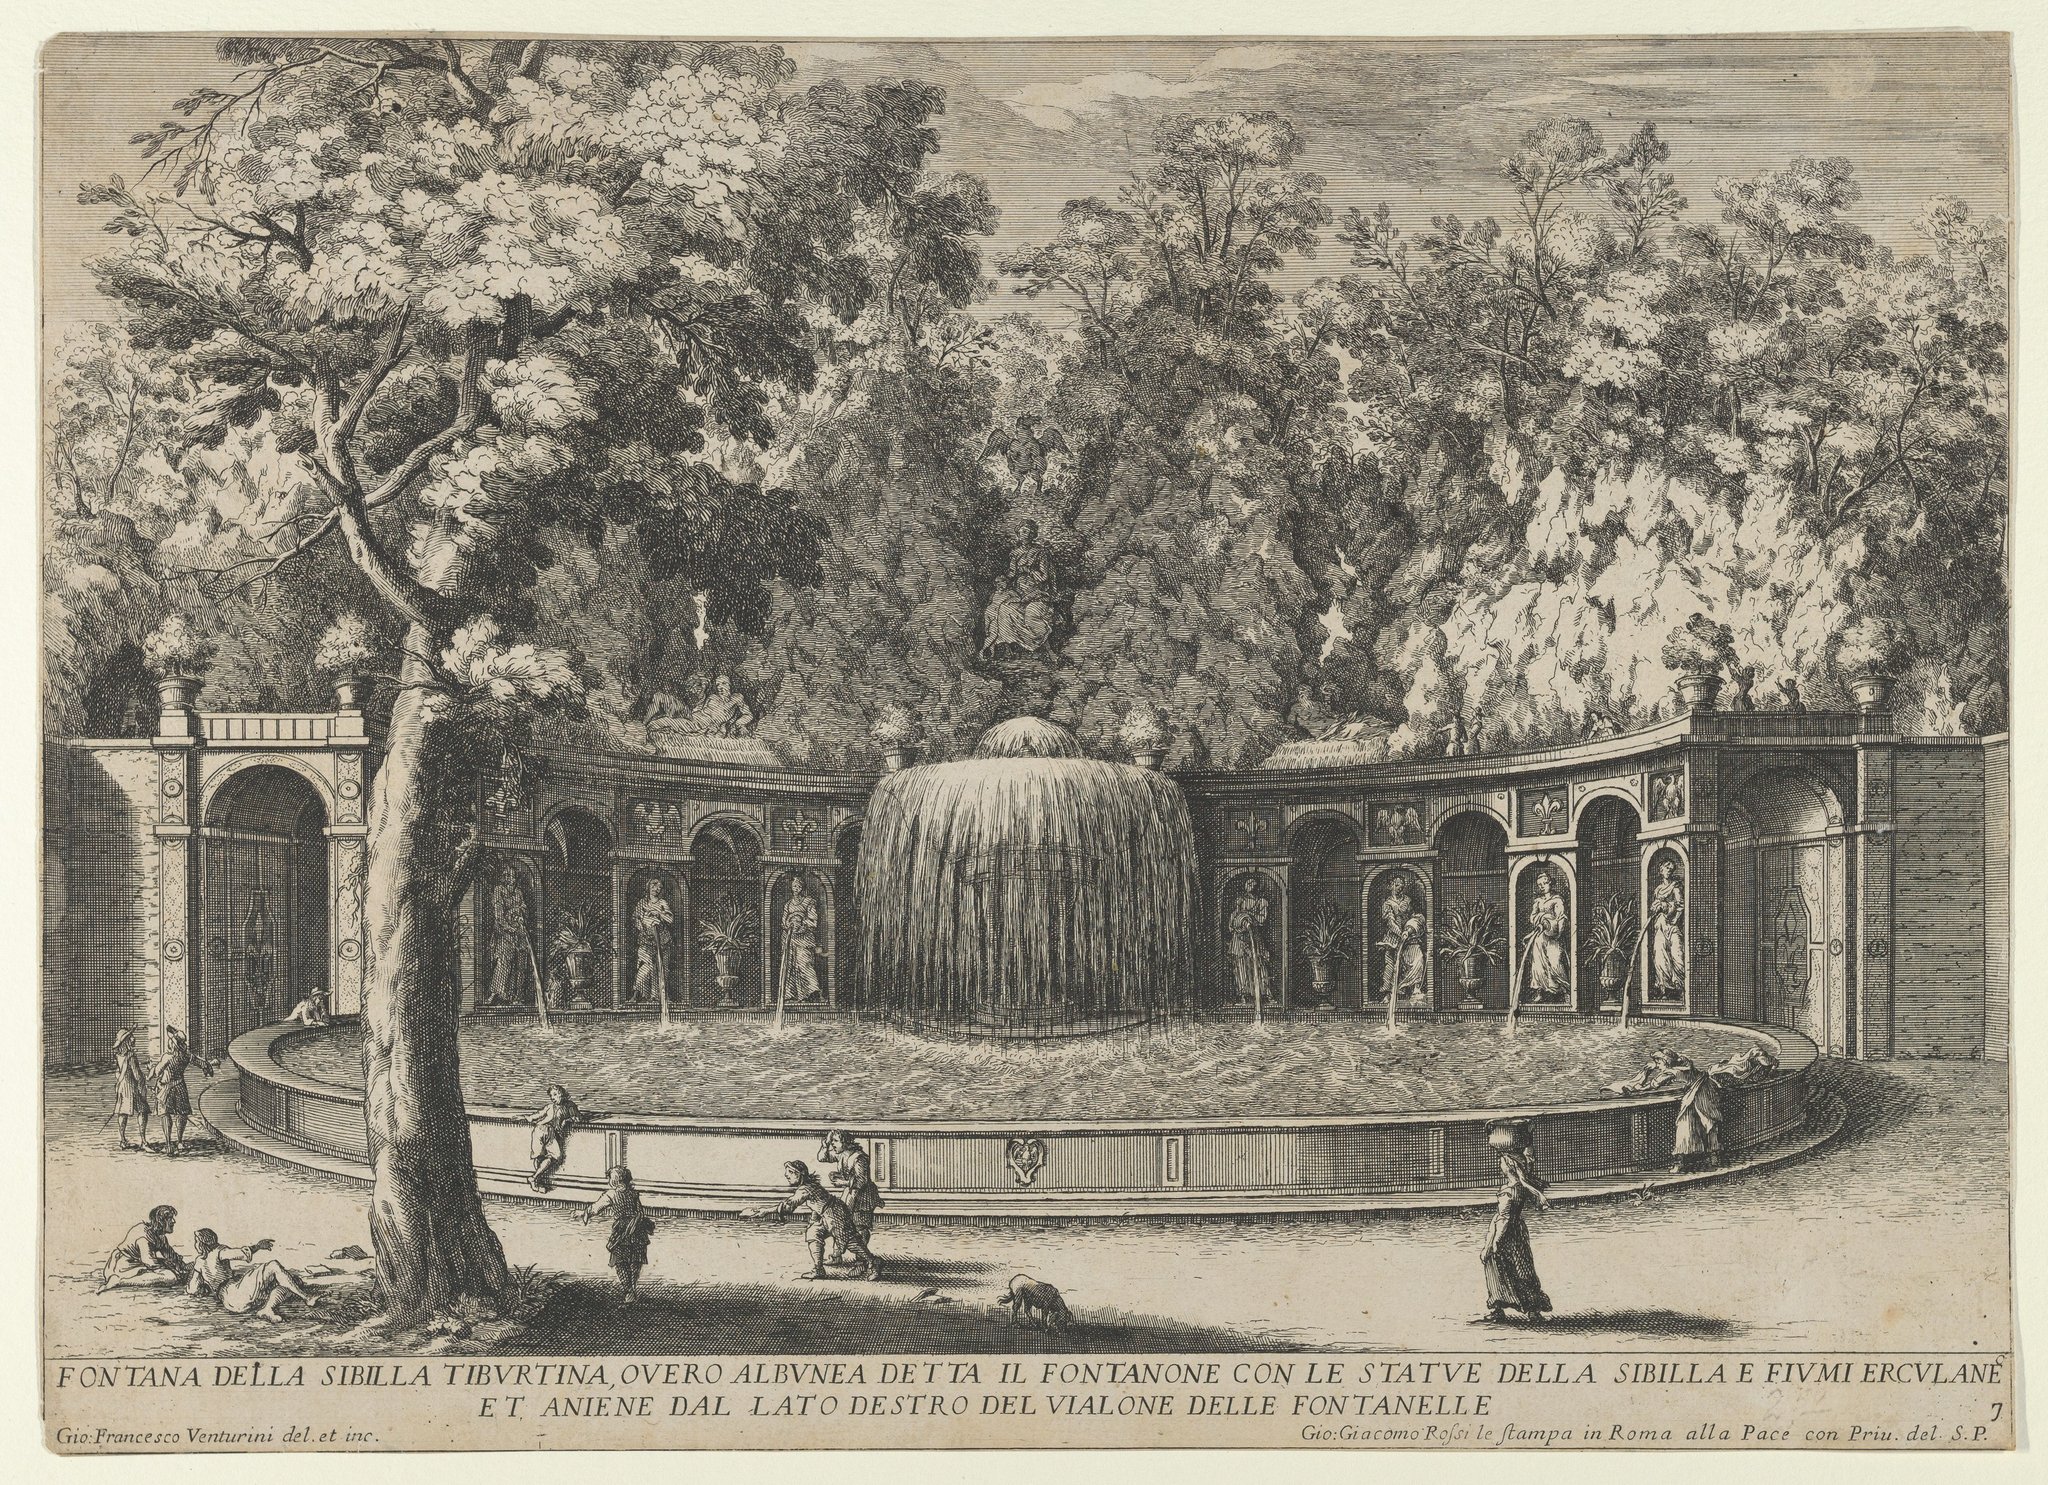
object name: print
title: Book IV, plate 7: the fountain of the Tiburtine sibyl in the garden at Villa d'Este, Tivoli, from "The fountains of the Este garden in Tivoli" (Le fontane del Giardino Estense in Tivoli)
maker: giovanni francesco venturini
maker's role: artist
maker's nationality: italian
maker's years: 1650-1700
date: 1676-1700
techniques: engraving, etching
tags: fountains,gardens